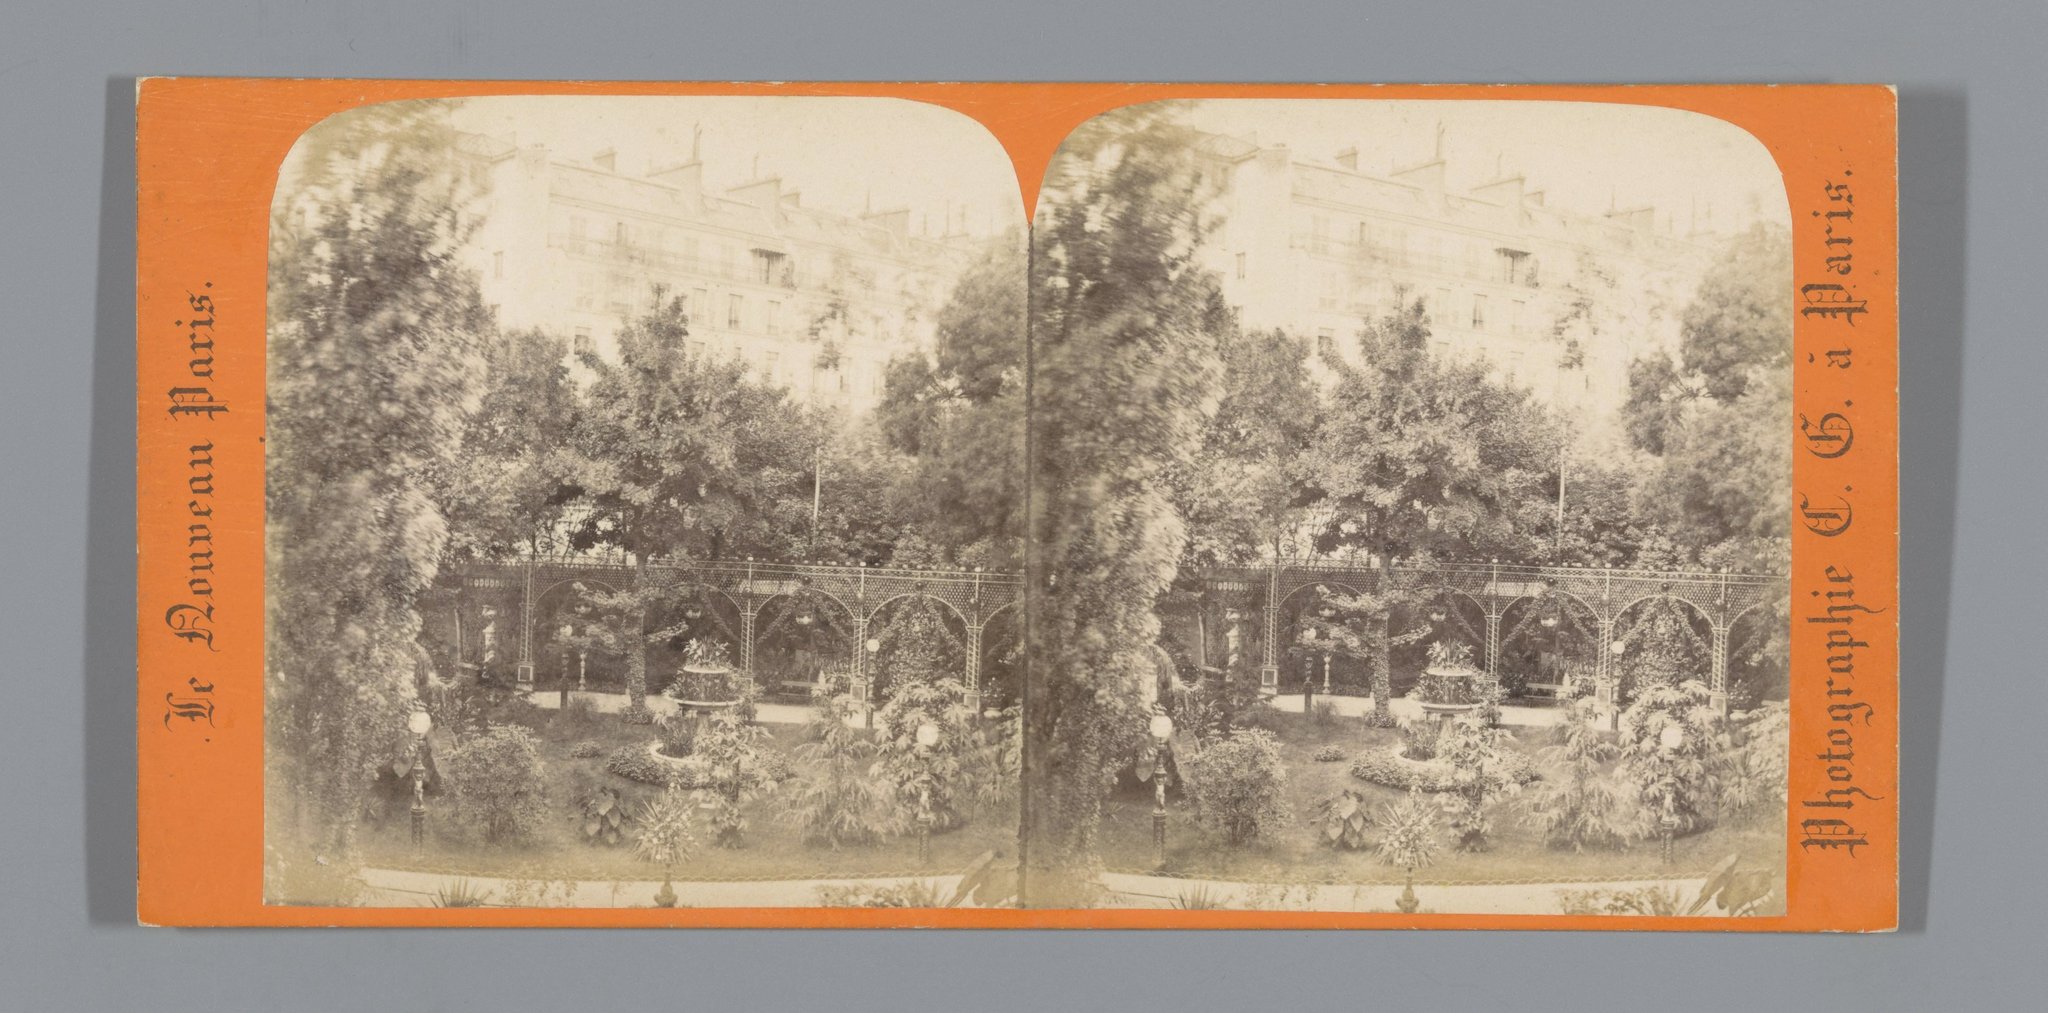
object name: stereograph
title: Le Nouveau Paris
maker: charles gérard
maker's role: fotograaf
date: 1860-1870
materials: cardboard, photographic support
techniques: albumen print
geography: bal mabille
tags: night-club, dance-hall, garden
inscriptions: inscription: ‘Jardin Mabille’, inscription: ‘Photographie C. G. à Paris.’